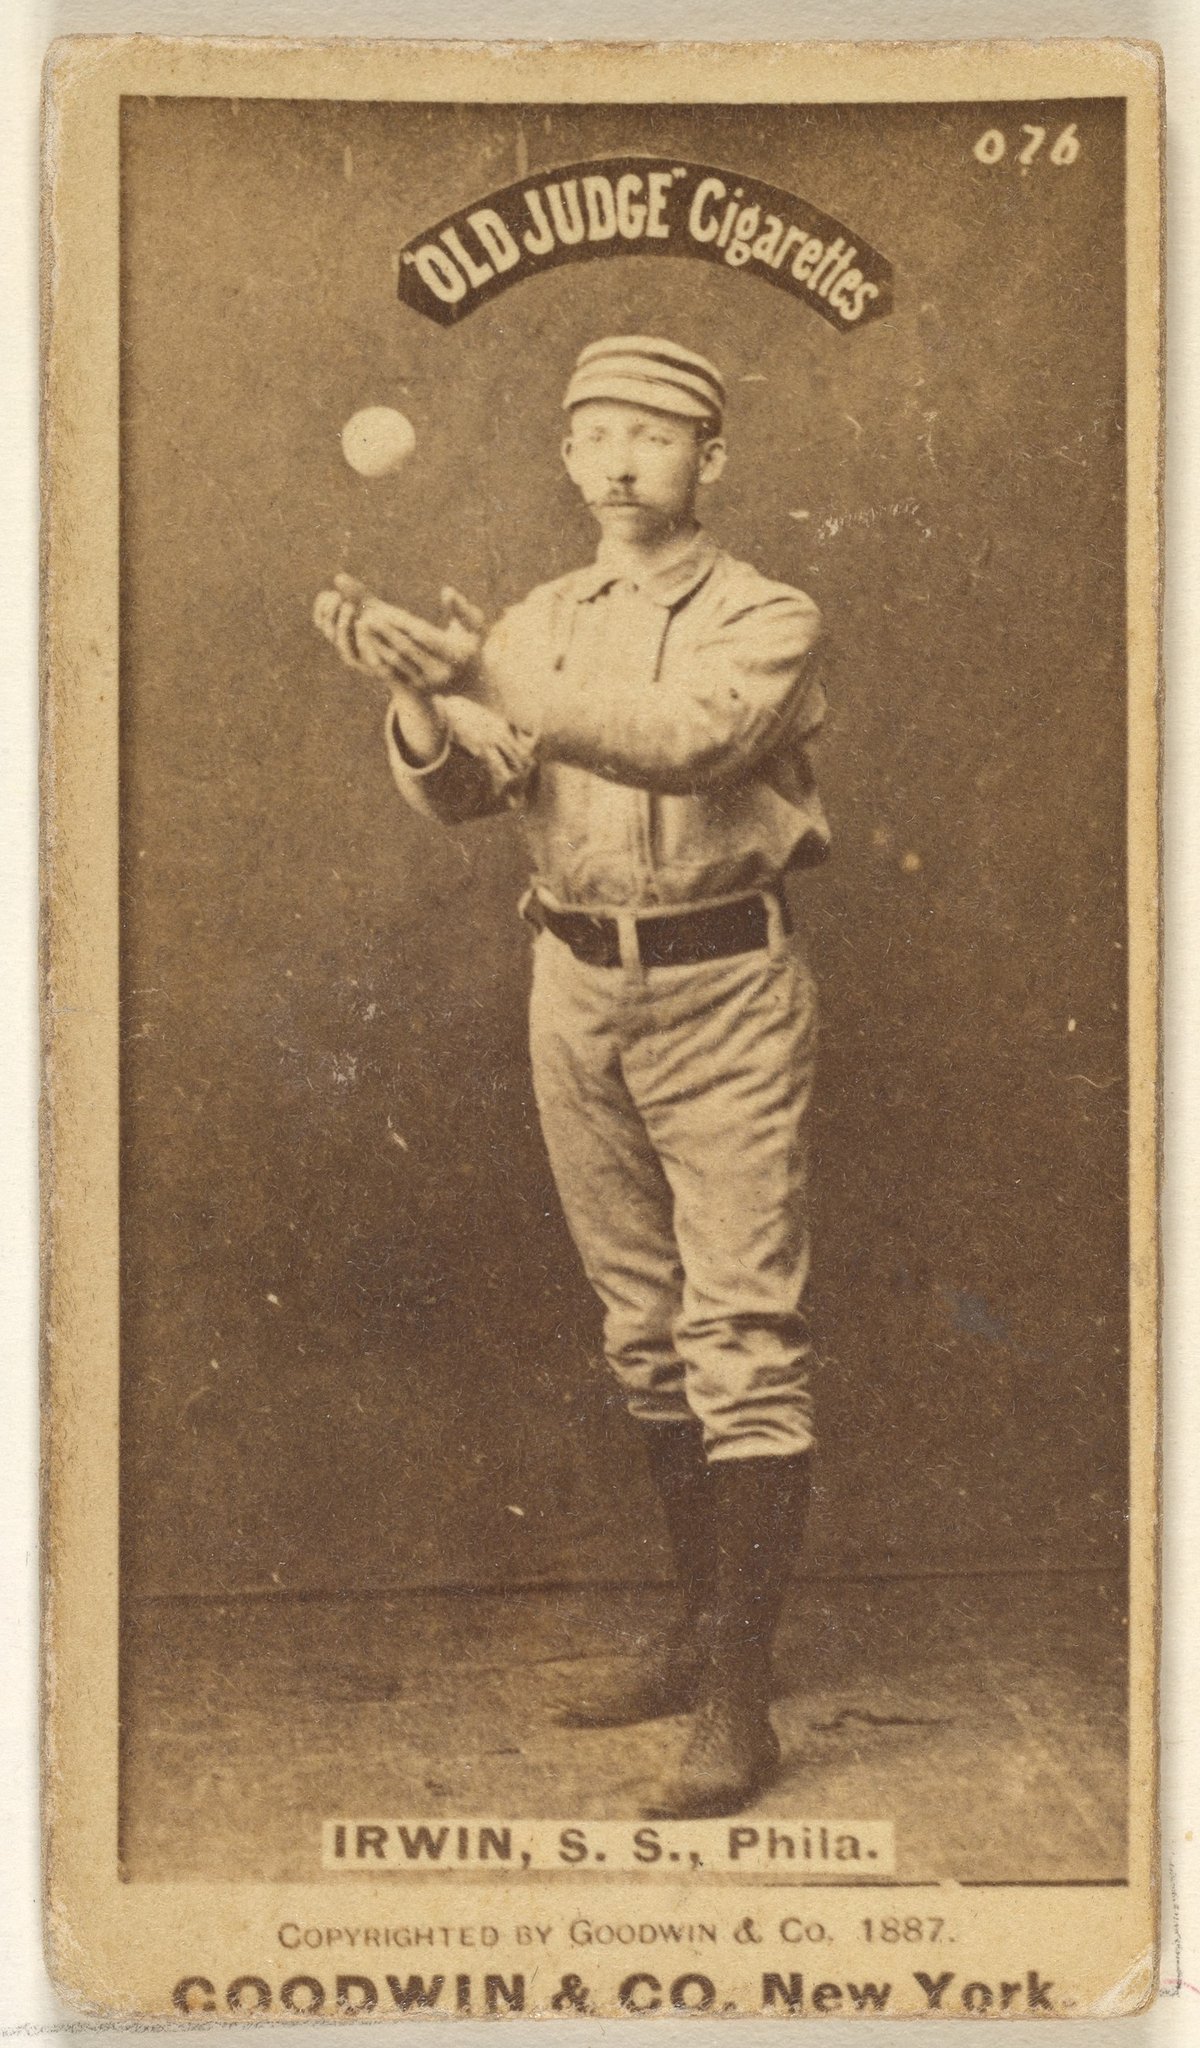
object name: baseball card, photograph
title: Arthur Albert "Doc" Irwin, Shortstop, Philadelphia, from the Old Judge series (N172) for Old Judge Cigarettes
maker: goodwin & company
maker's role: publisher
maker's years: 1850-1950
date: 1887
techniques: albumen silver print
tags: men,portraits,baseball,athletes